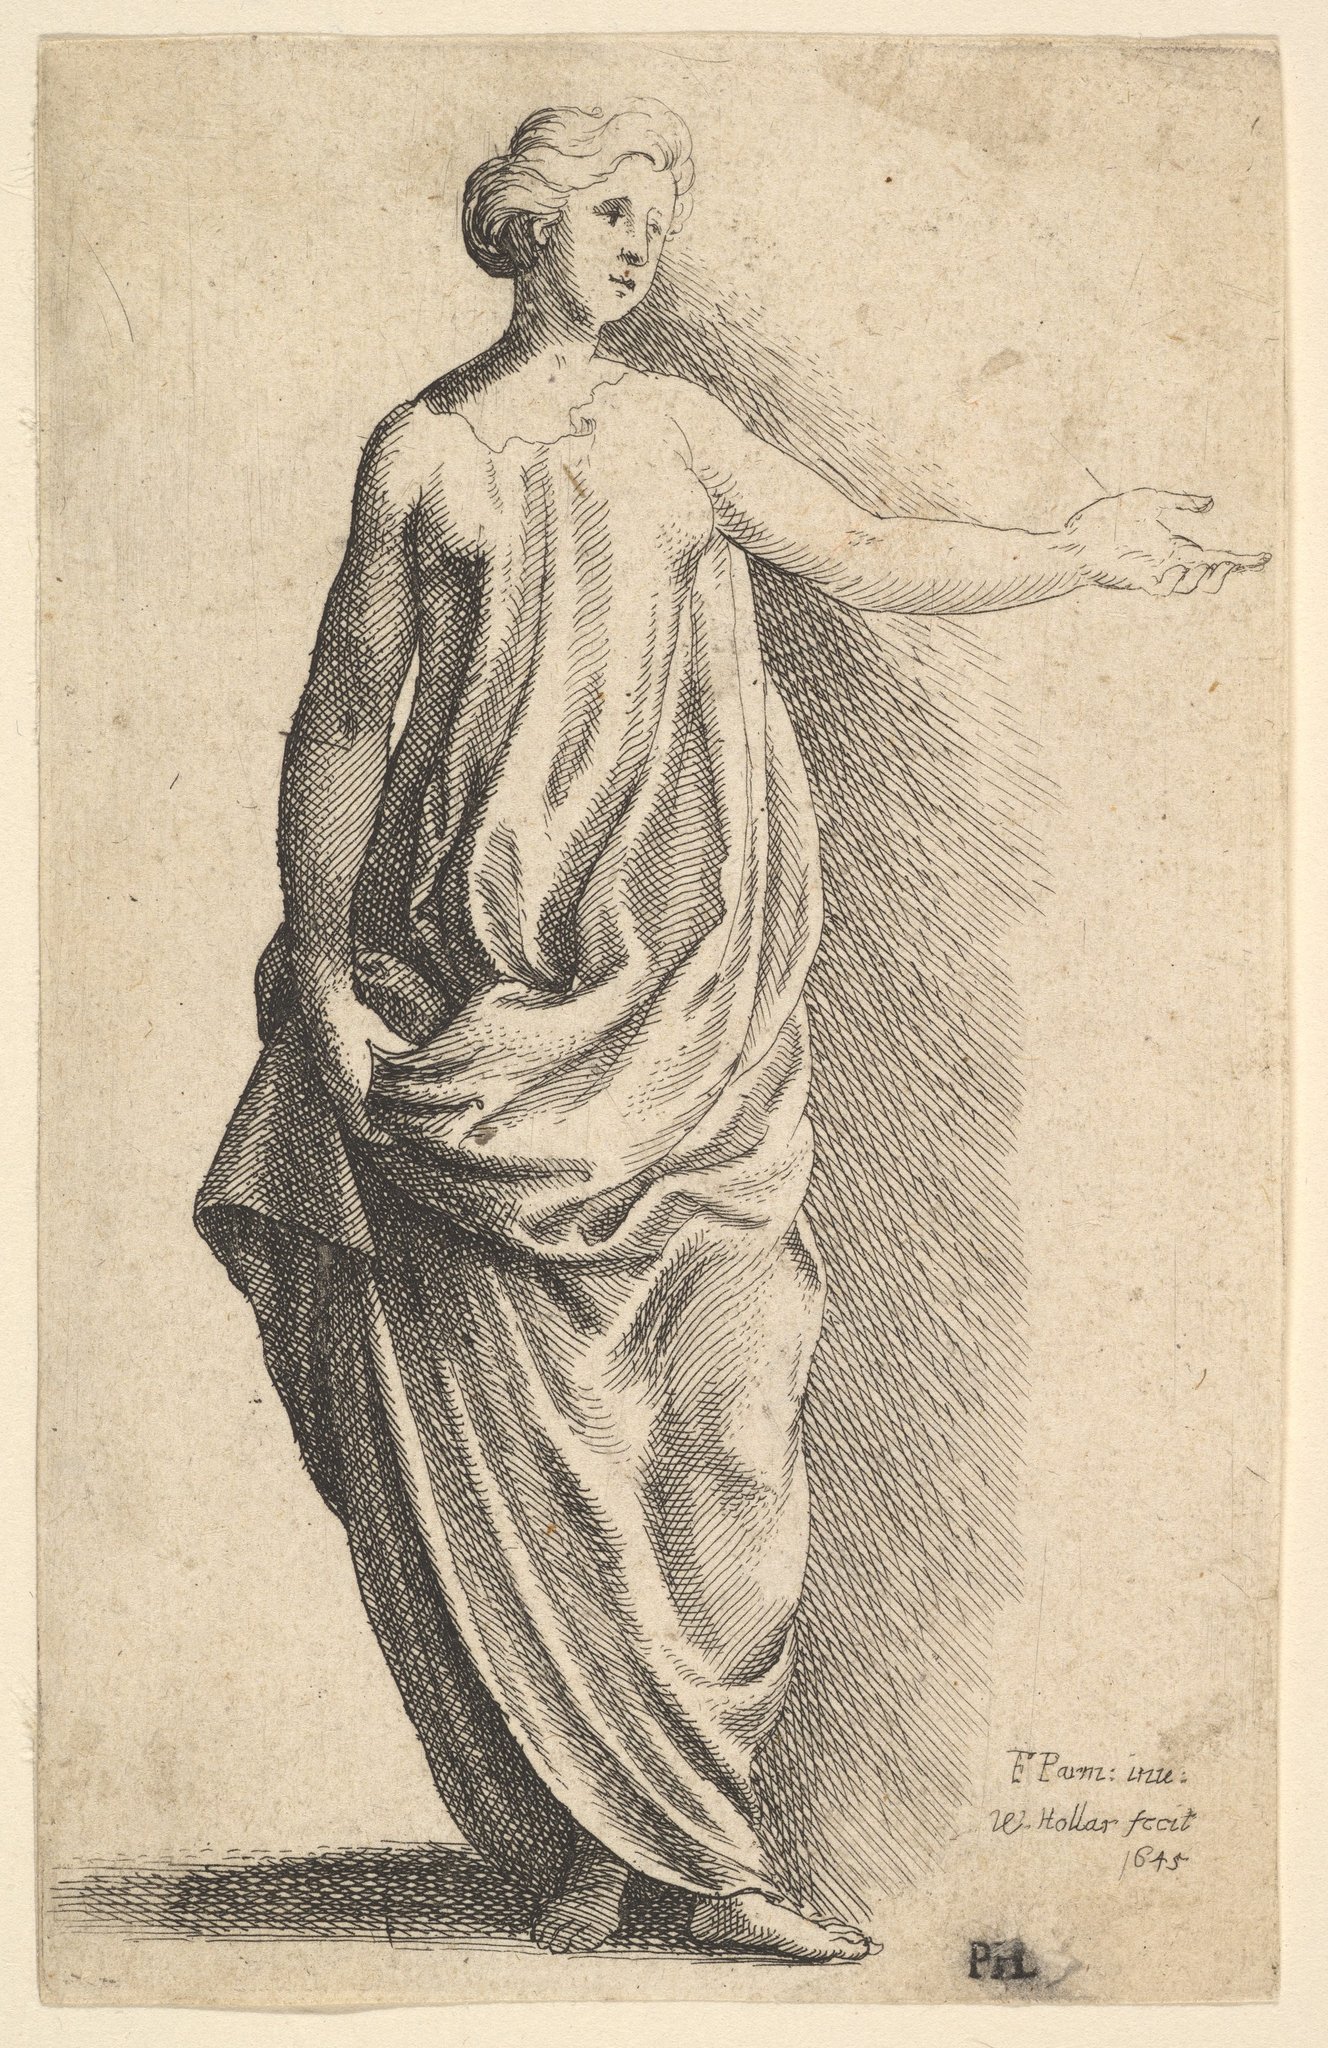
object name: print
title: Standing female figure in loose classical robe, with arm outstretched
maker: wenceslaus hollar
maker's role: artist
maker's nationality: bohemian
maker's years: 1607-1677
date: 1645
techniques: etching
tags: women